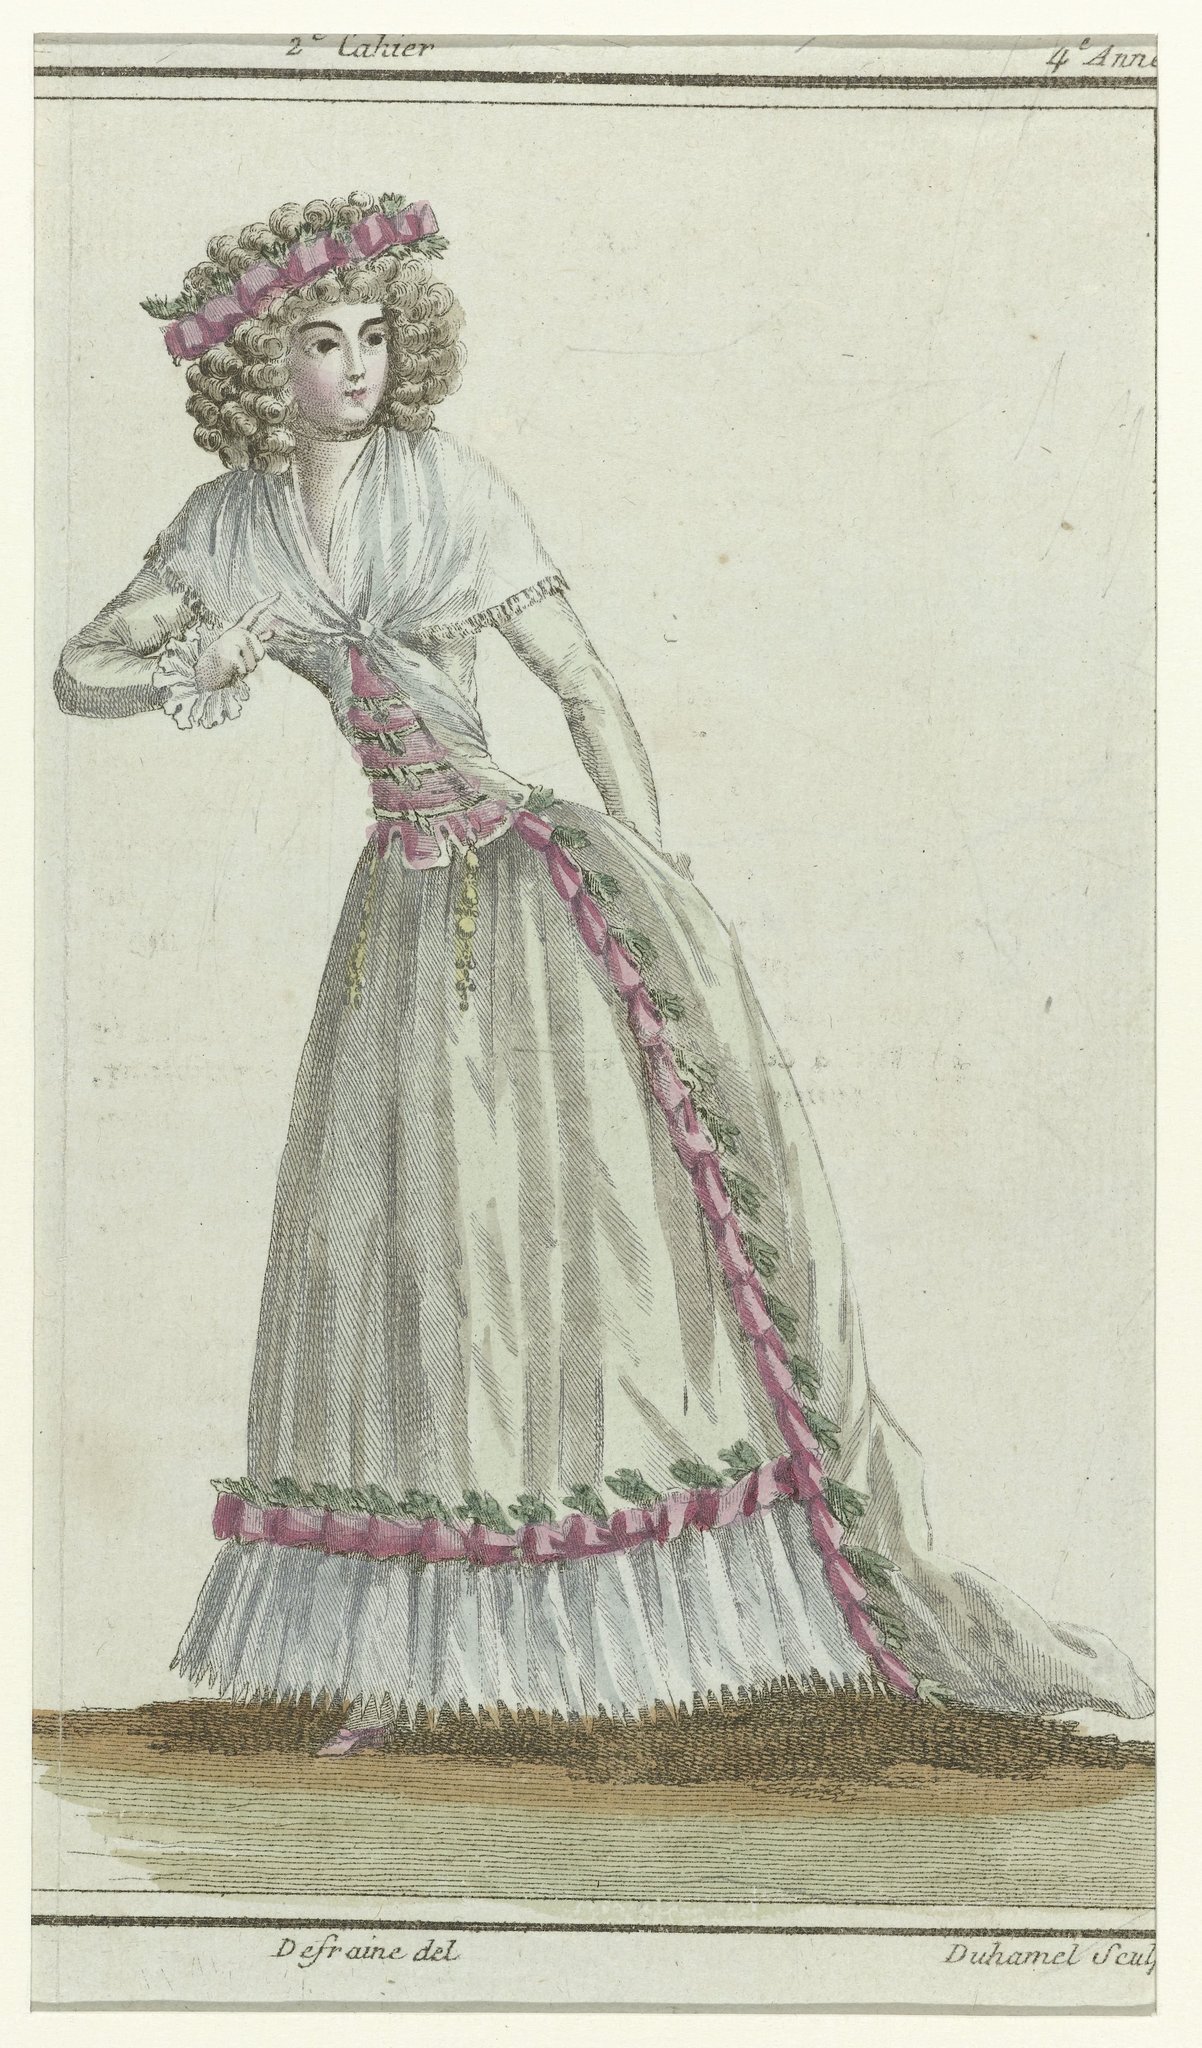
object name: fashion print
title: Magasin des Modes Nouvelles Françaises et Anglaises, 11 décembre 1788, 4e Année, 2e cahier, Pl. 3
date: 1788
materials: paper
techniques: engraving, hand coloring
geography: paris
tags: clothing for the upper part of the body (+ women's clothes), dress, gown: ball gown (+ women's clothes), border, ribbon, braid (+ women's clothes), fashion plates, shoes, sandals (+ women's clothes), skirt (+ women's clothes), piece of clothing covering the breast or décolleté (fichu) (+ women's clothes)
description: Vrouw in 'habit de bal' of baljapon met sleep. De witte japon en onderrok zijn versierd met roze lint. Korset van roze satijn. Fichu om de schouders. Twee chatelaines. De prent maakt deel uit van het 2e Cahier, 4e année, uit de serie Magasin des Modes Nouvelles Françaises et Anglaises. De serie bestaat uit 172 modeprenten, uitgegeven door Buisson, Parijs, 20 november 1786 - 21 décembre 1789.